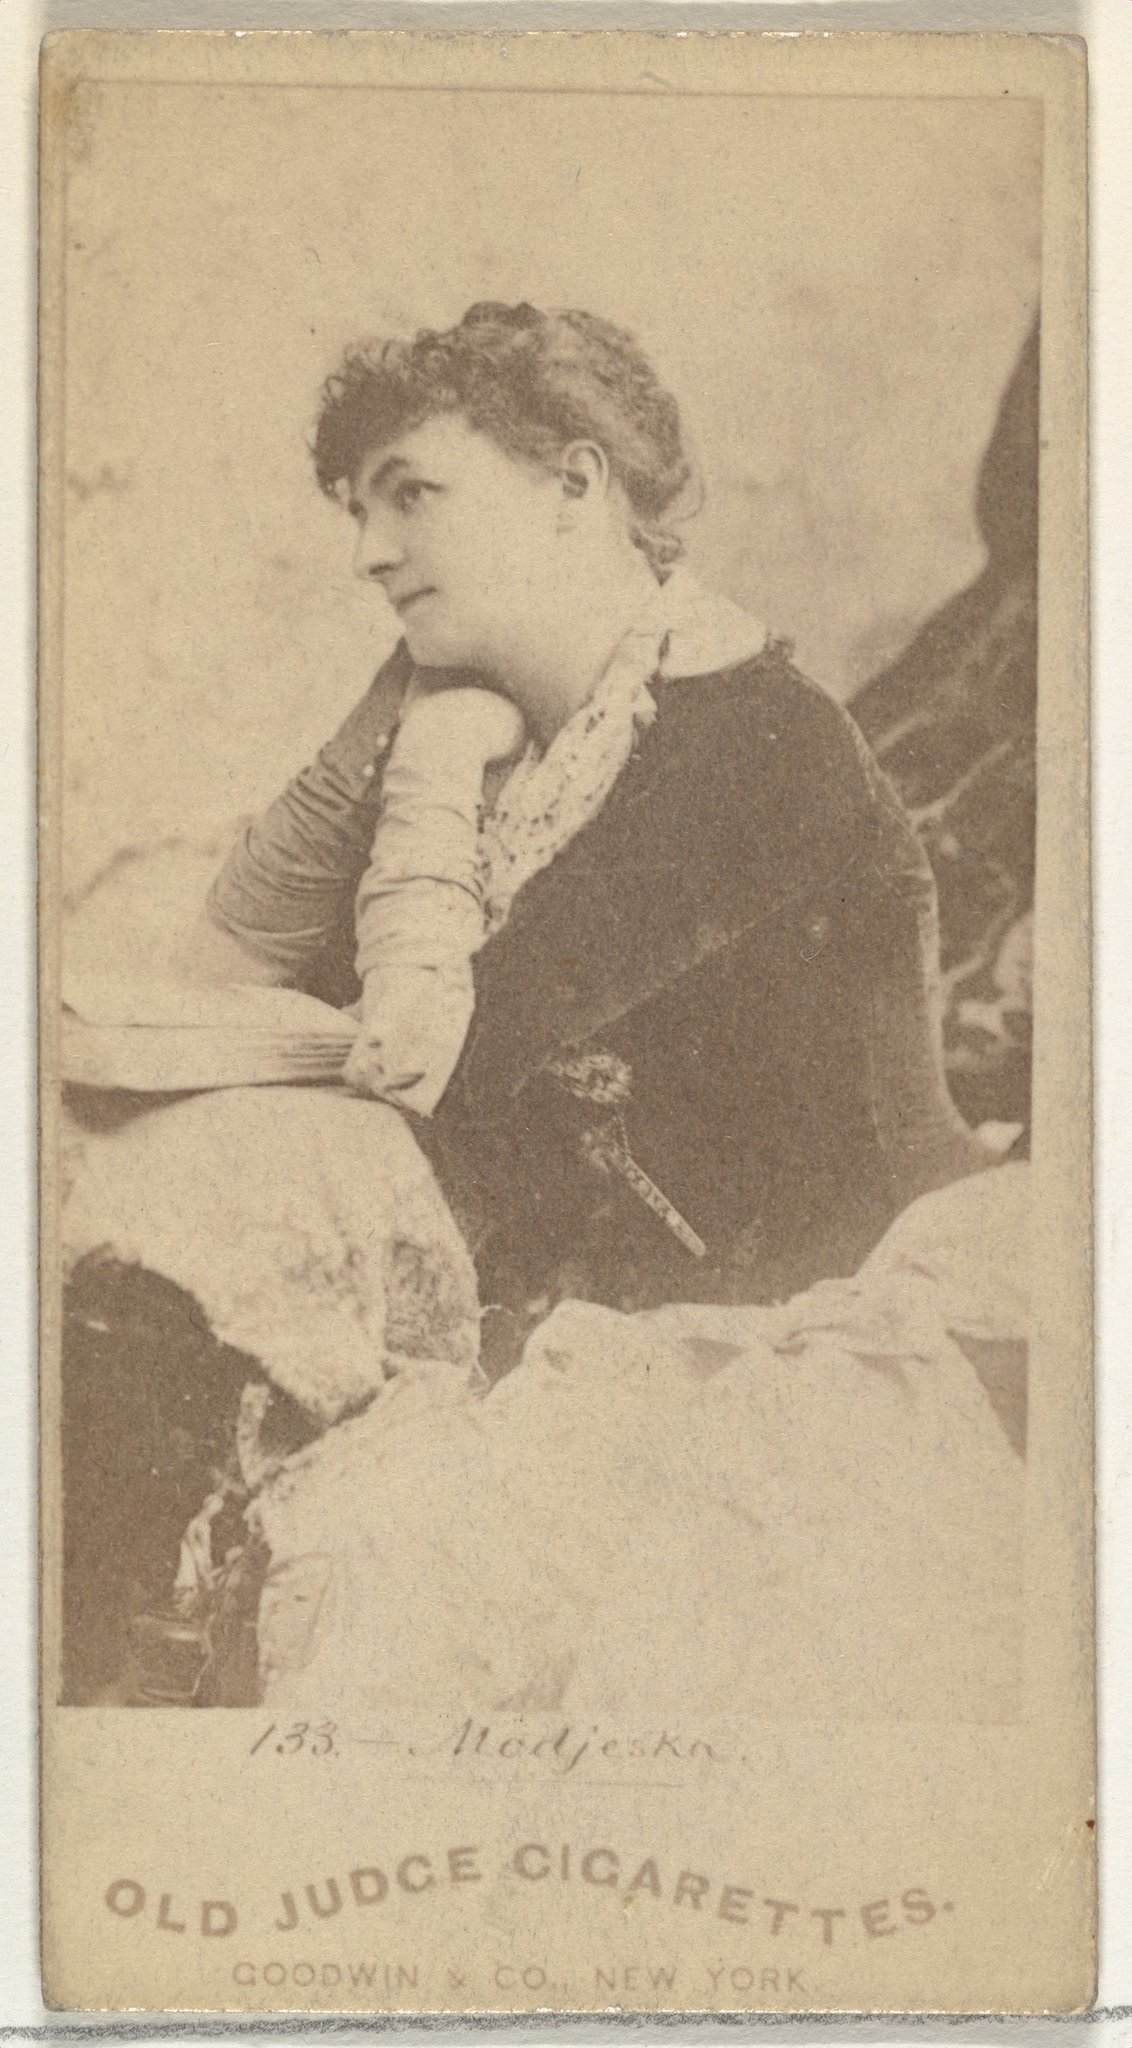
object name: photograph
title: Modjeska, from the Actors and Actresses series (N171) for Old Judge Cigarettes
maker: goodwin & company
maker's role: publisher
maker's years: 1850-1950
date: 1886-1890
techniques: albumen silver print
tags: portraits,women,actresses